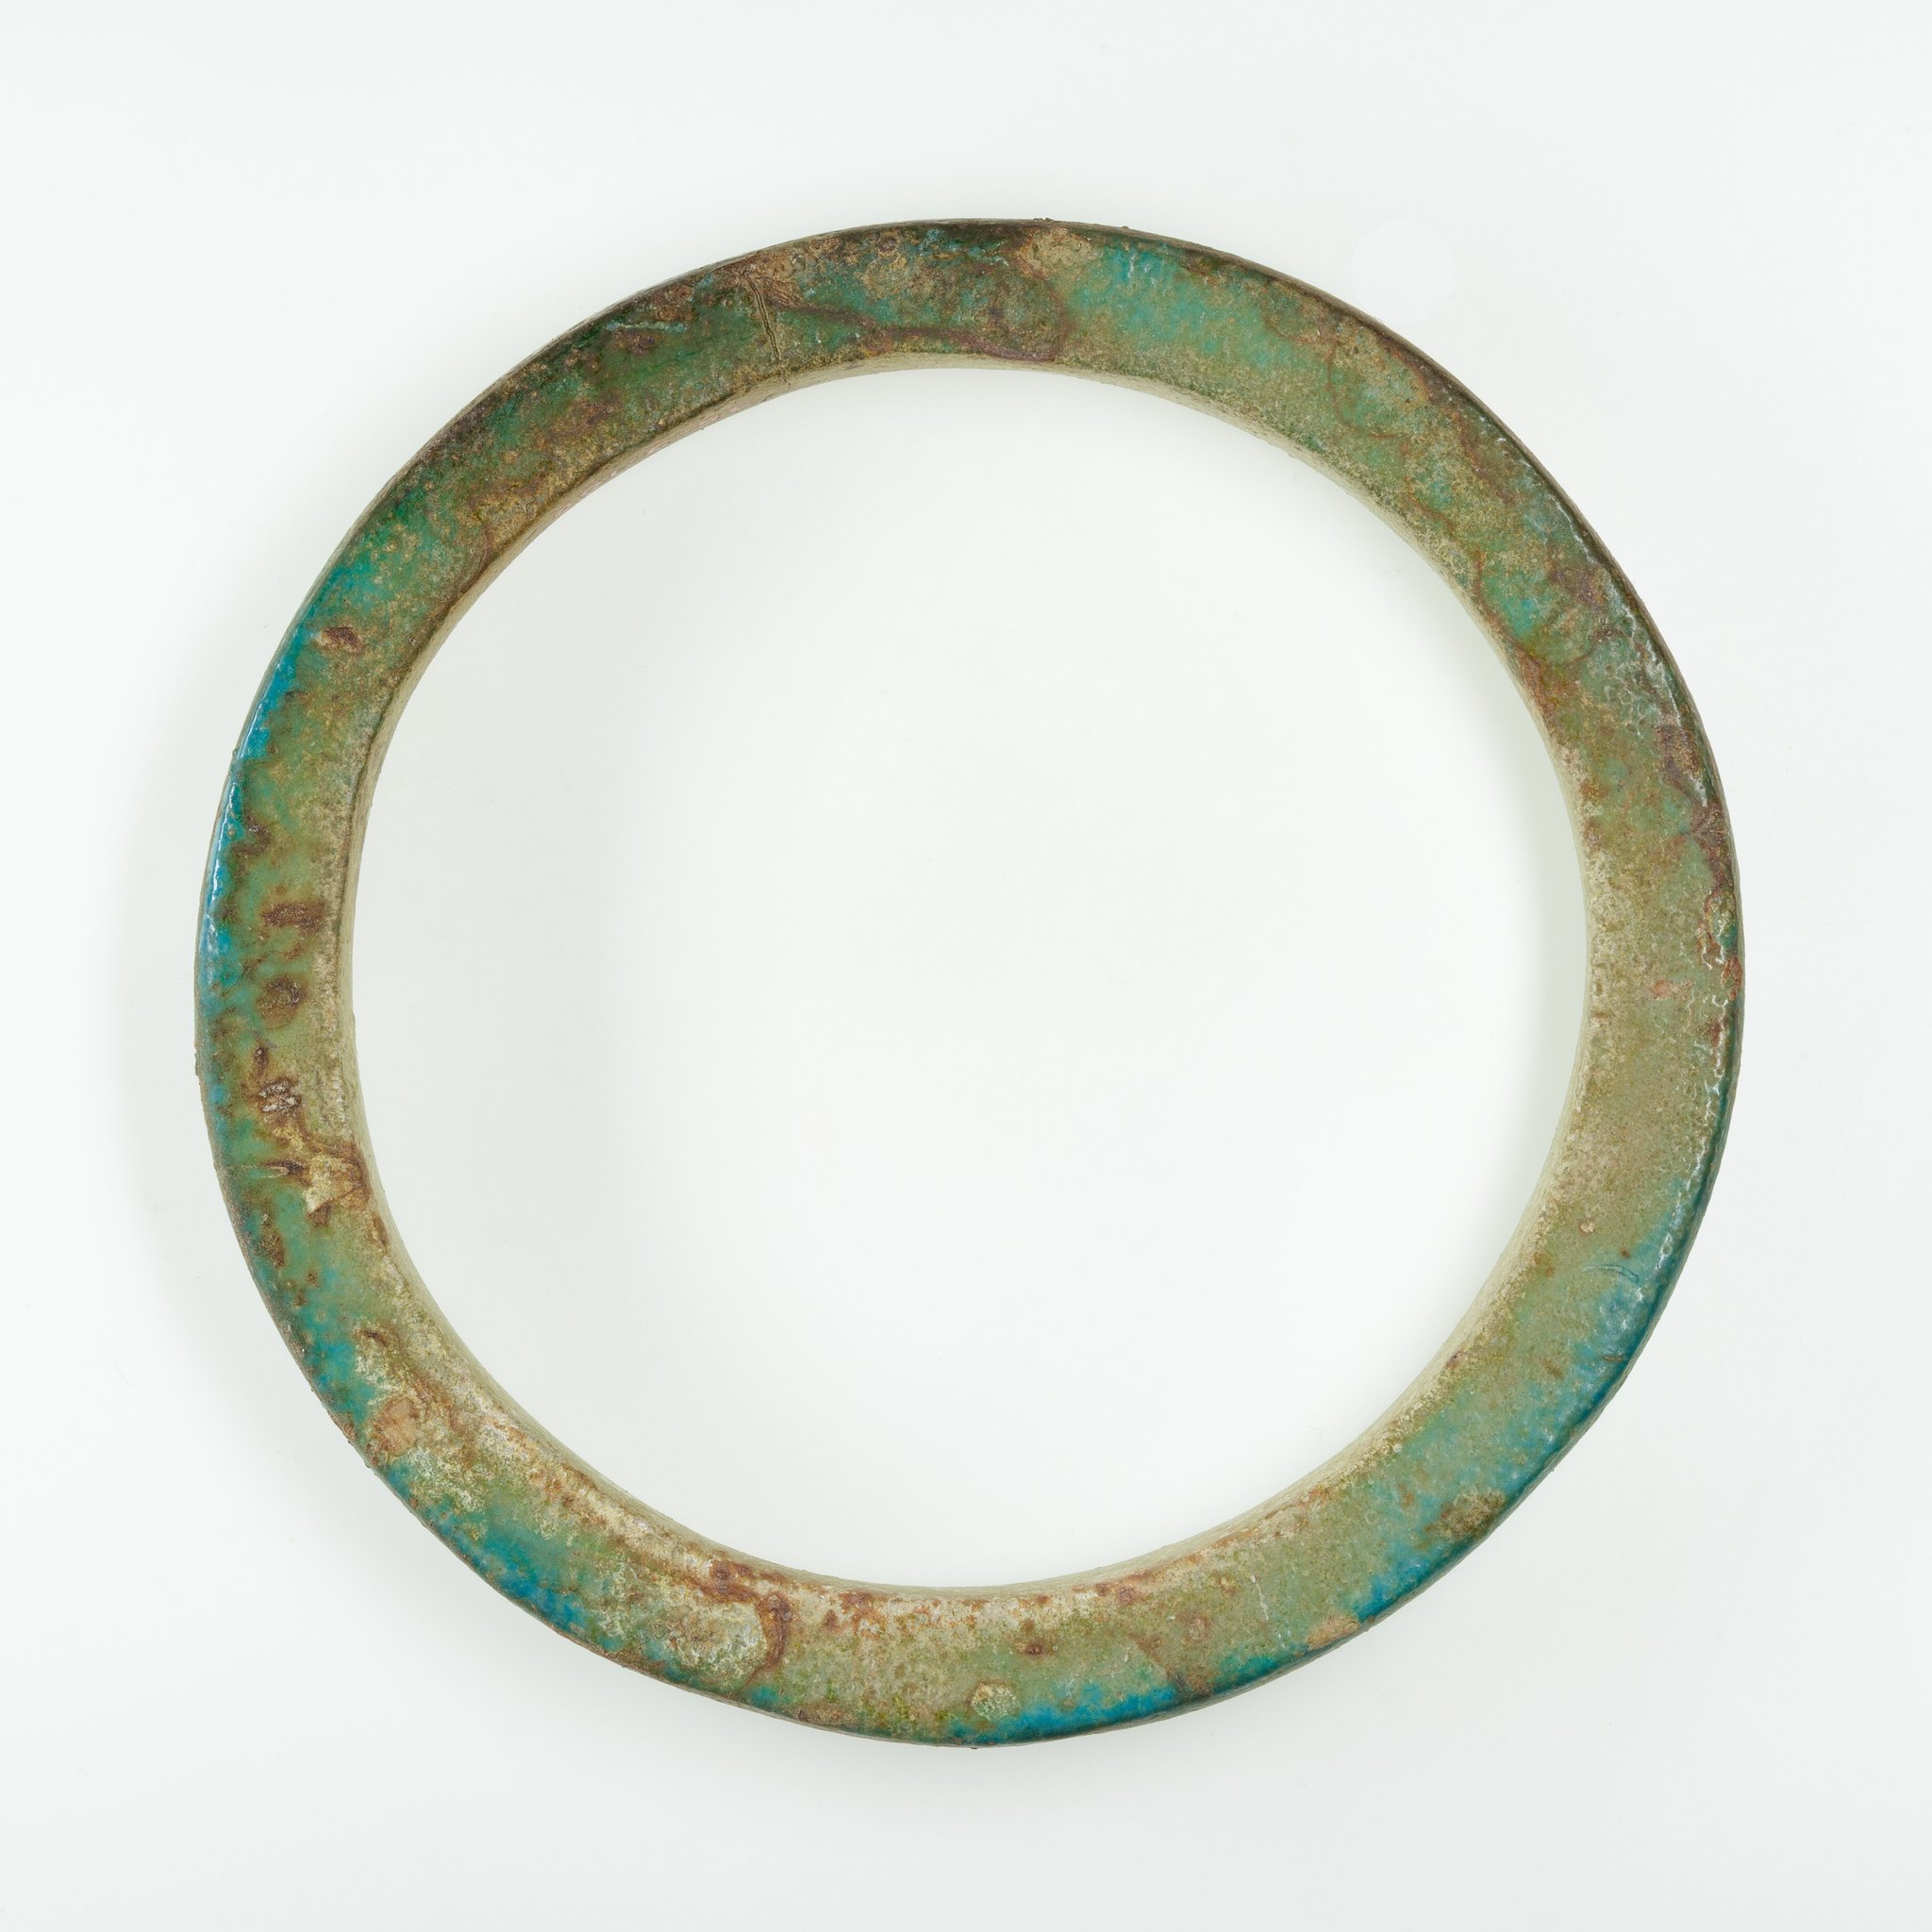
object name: bracelet, armlet, neferkhawet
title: Armlet of Neferkhawet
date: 1504-1447 BCE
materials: faience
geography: egypt